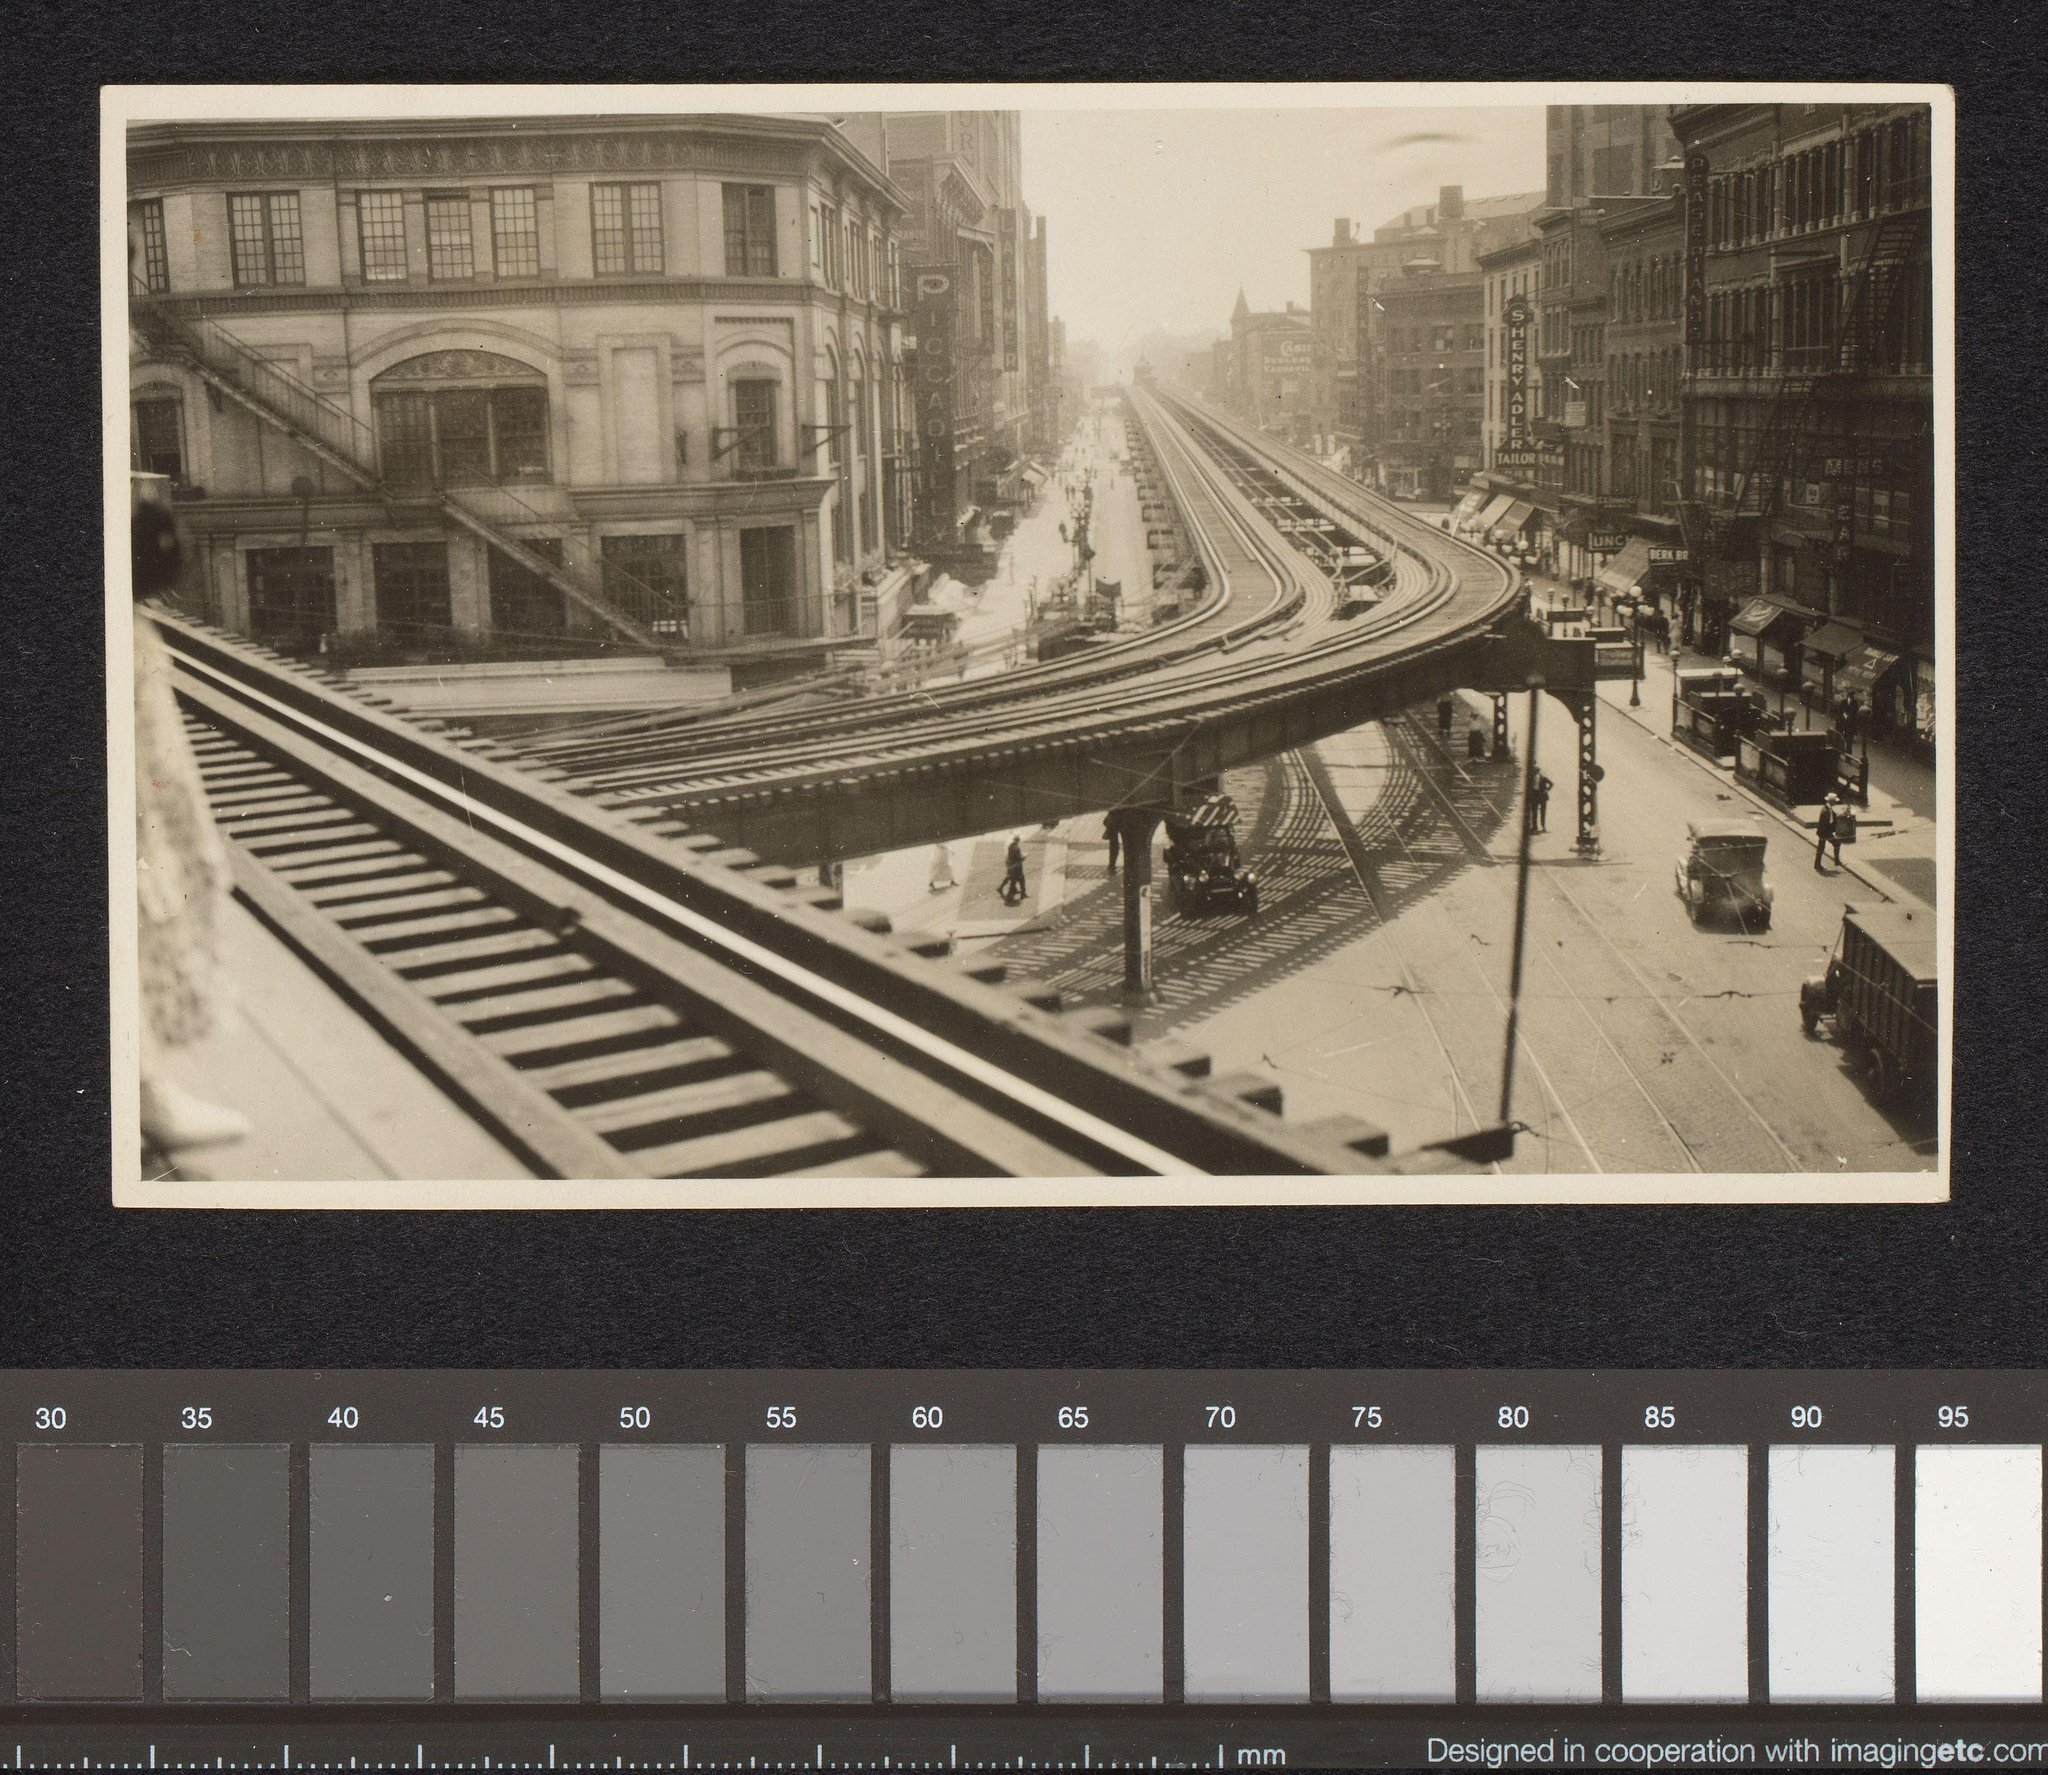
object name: photograph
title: Elevated New York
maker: Anonymous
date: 1920-1930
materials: paper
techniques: gelatin silver print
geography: new york city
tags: railway, train